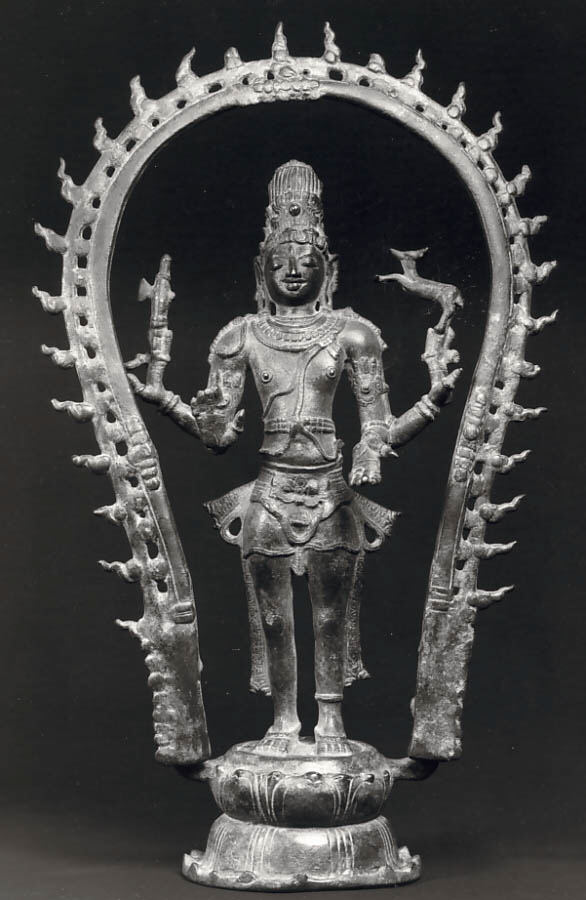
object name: figure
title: Standing Shiva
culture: indian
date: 901-1100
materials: bronze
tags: shiva,hinduism